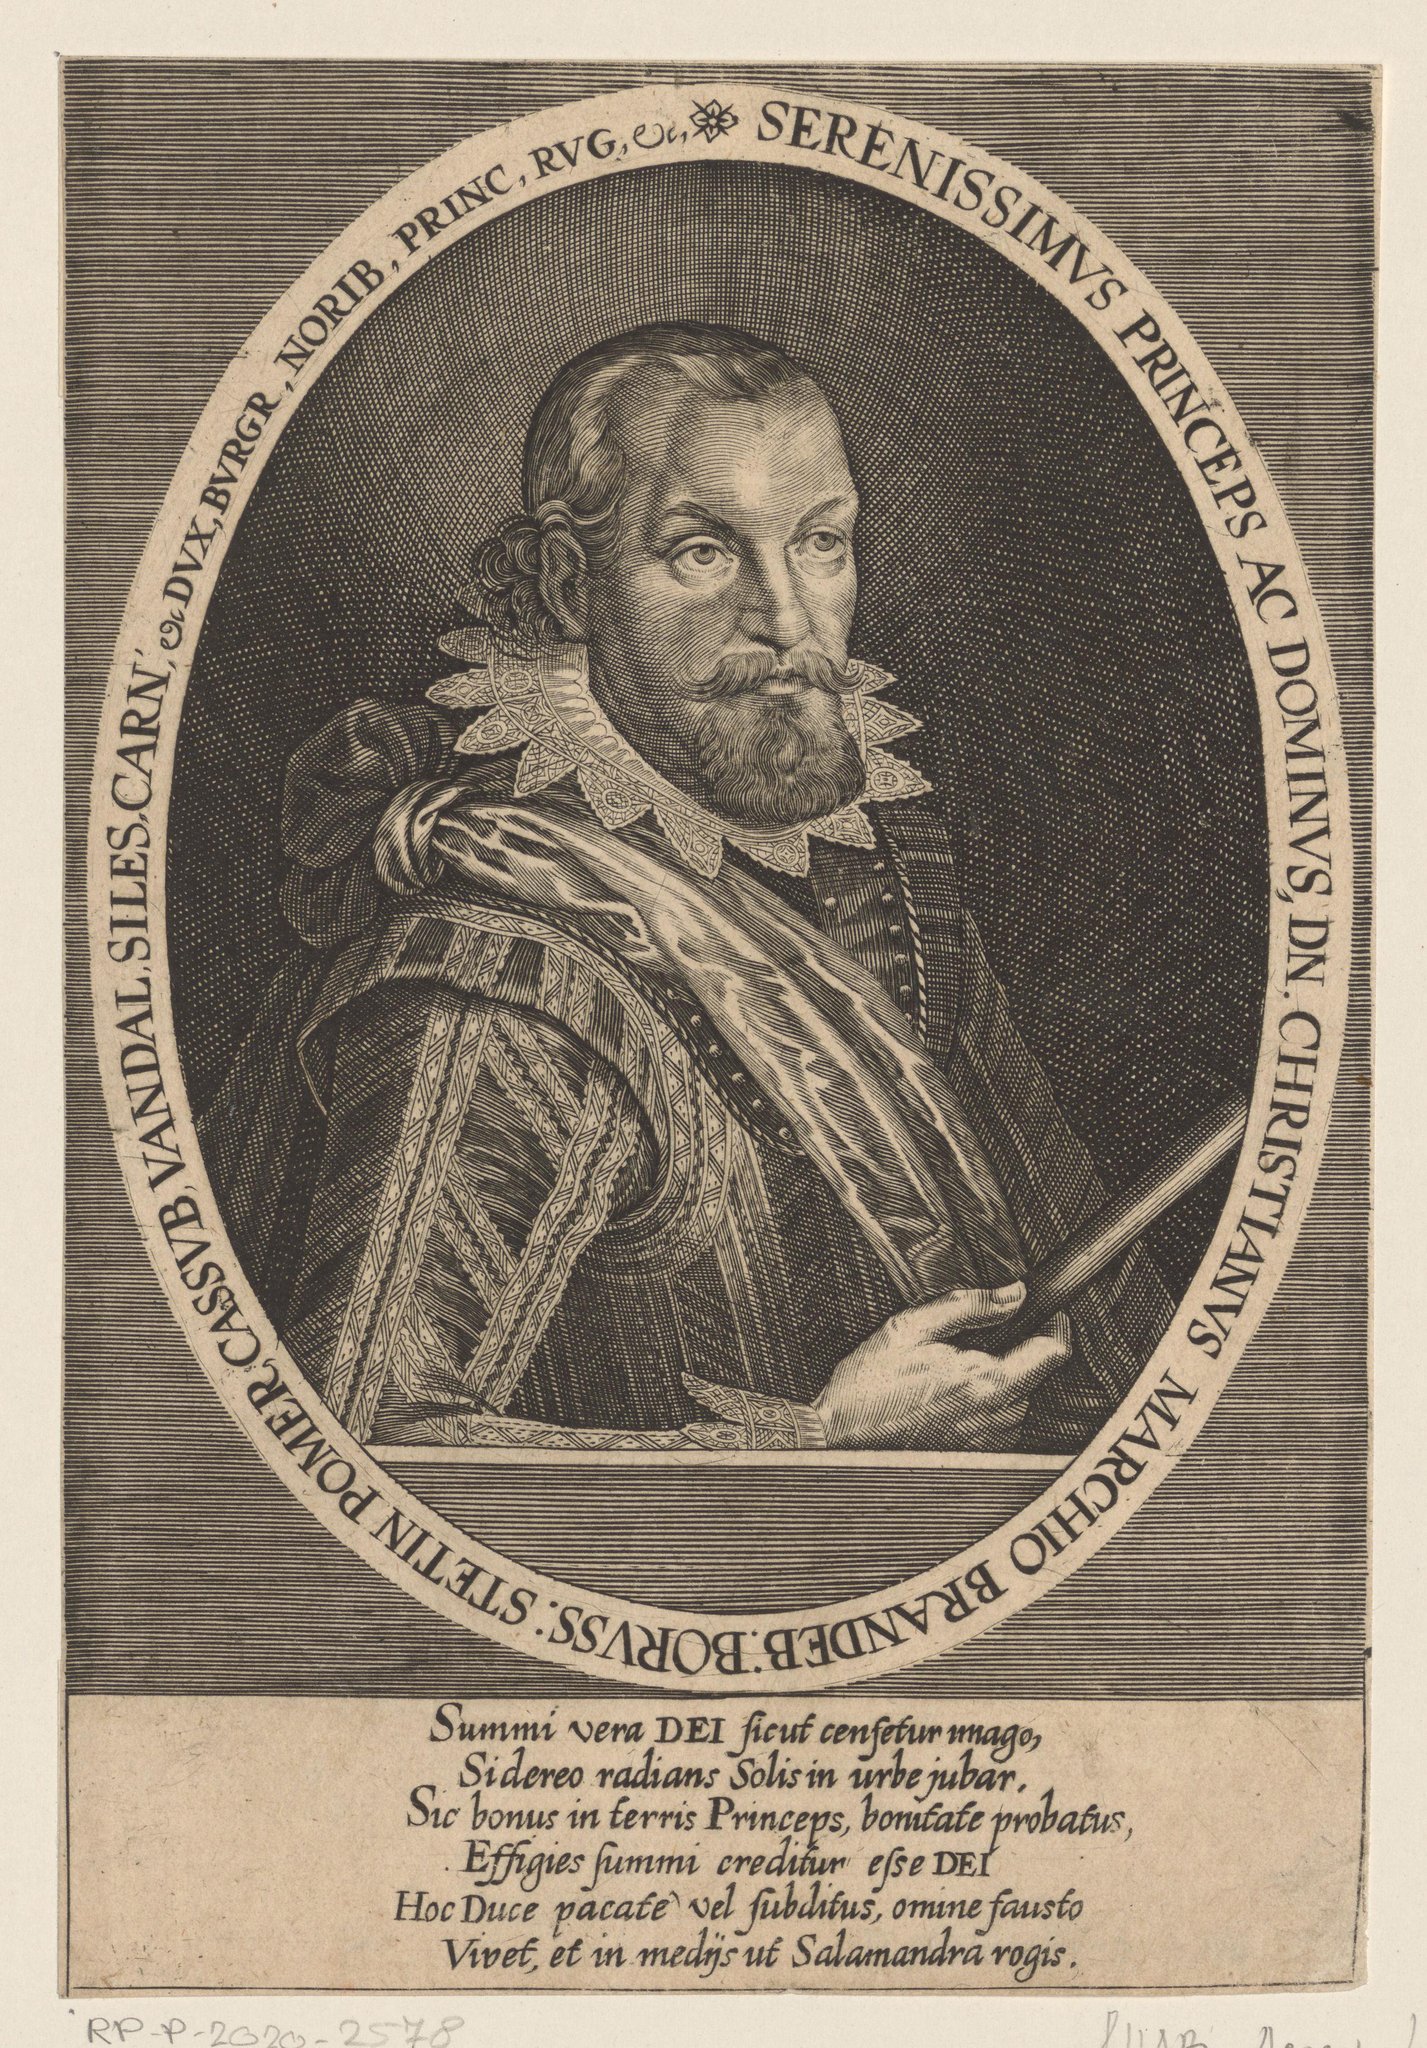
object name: print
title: Portret van Christiaan van Brandenburg-Bayreuth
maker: Anonymous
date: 1601-1657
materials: paper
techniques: engraving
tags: historical persons